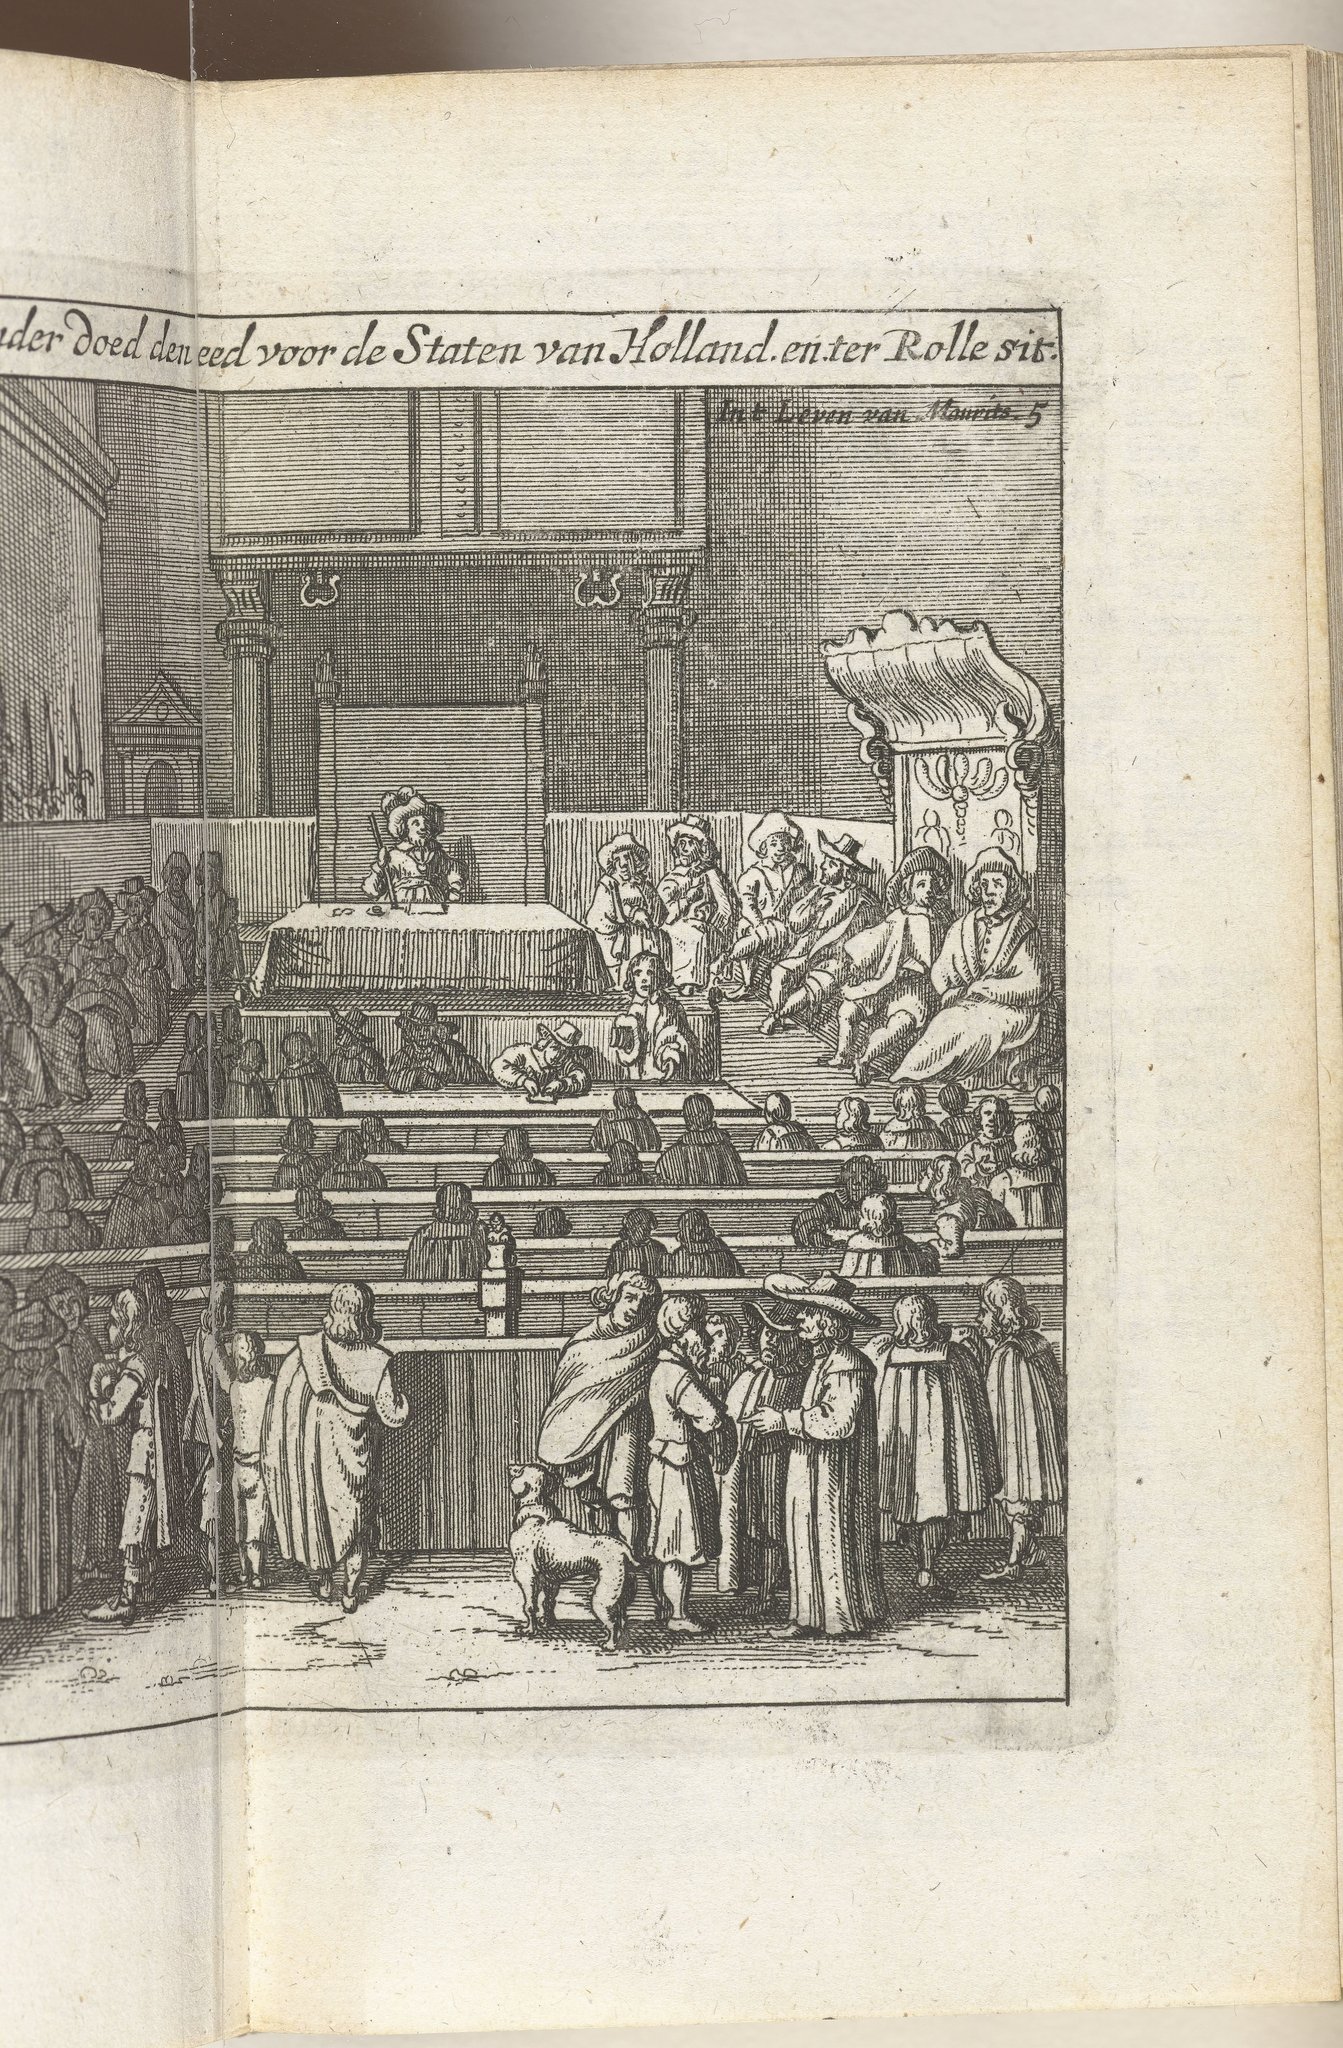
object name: book illustration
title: Maurits ingezworen als stadhouder van Holland, 1584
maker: Anonymous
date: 1662-1664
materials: paper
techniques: etching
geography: northern netherlands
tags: maurice (prince of orange), new ruler taking the oath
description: Illustratie in: A. Montanus, 'T leven en bedryf der prinsen van Oranje, Wilhelm de eerste, Maurits, Frederik Henrik, Wilhem de tweede, Wilhem de derde : aengehecht met de daden der Nassouwsche stam, van het jaar 682 tot dese tyd, 5 delen in 2 banden, A. Montanus, Amsterdam 1664. Band I: deel Maurits, p. 4-5. In het exemplaar in de collectie van de Rijksmuseum Research Library (330 F 12-13).